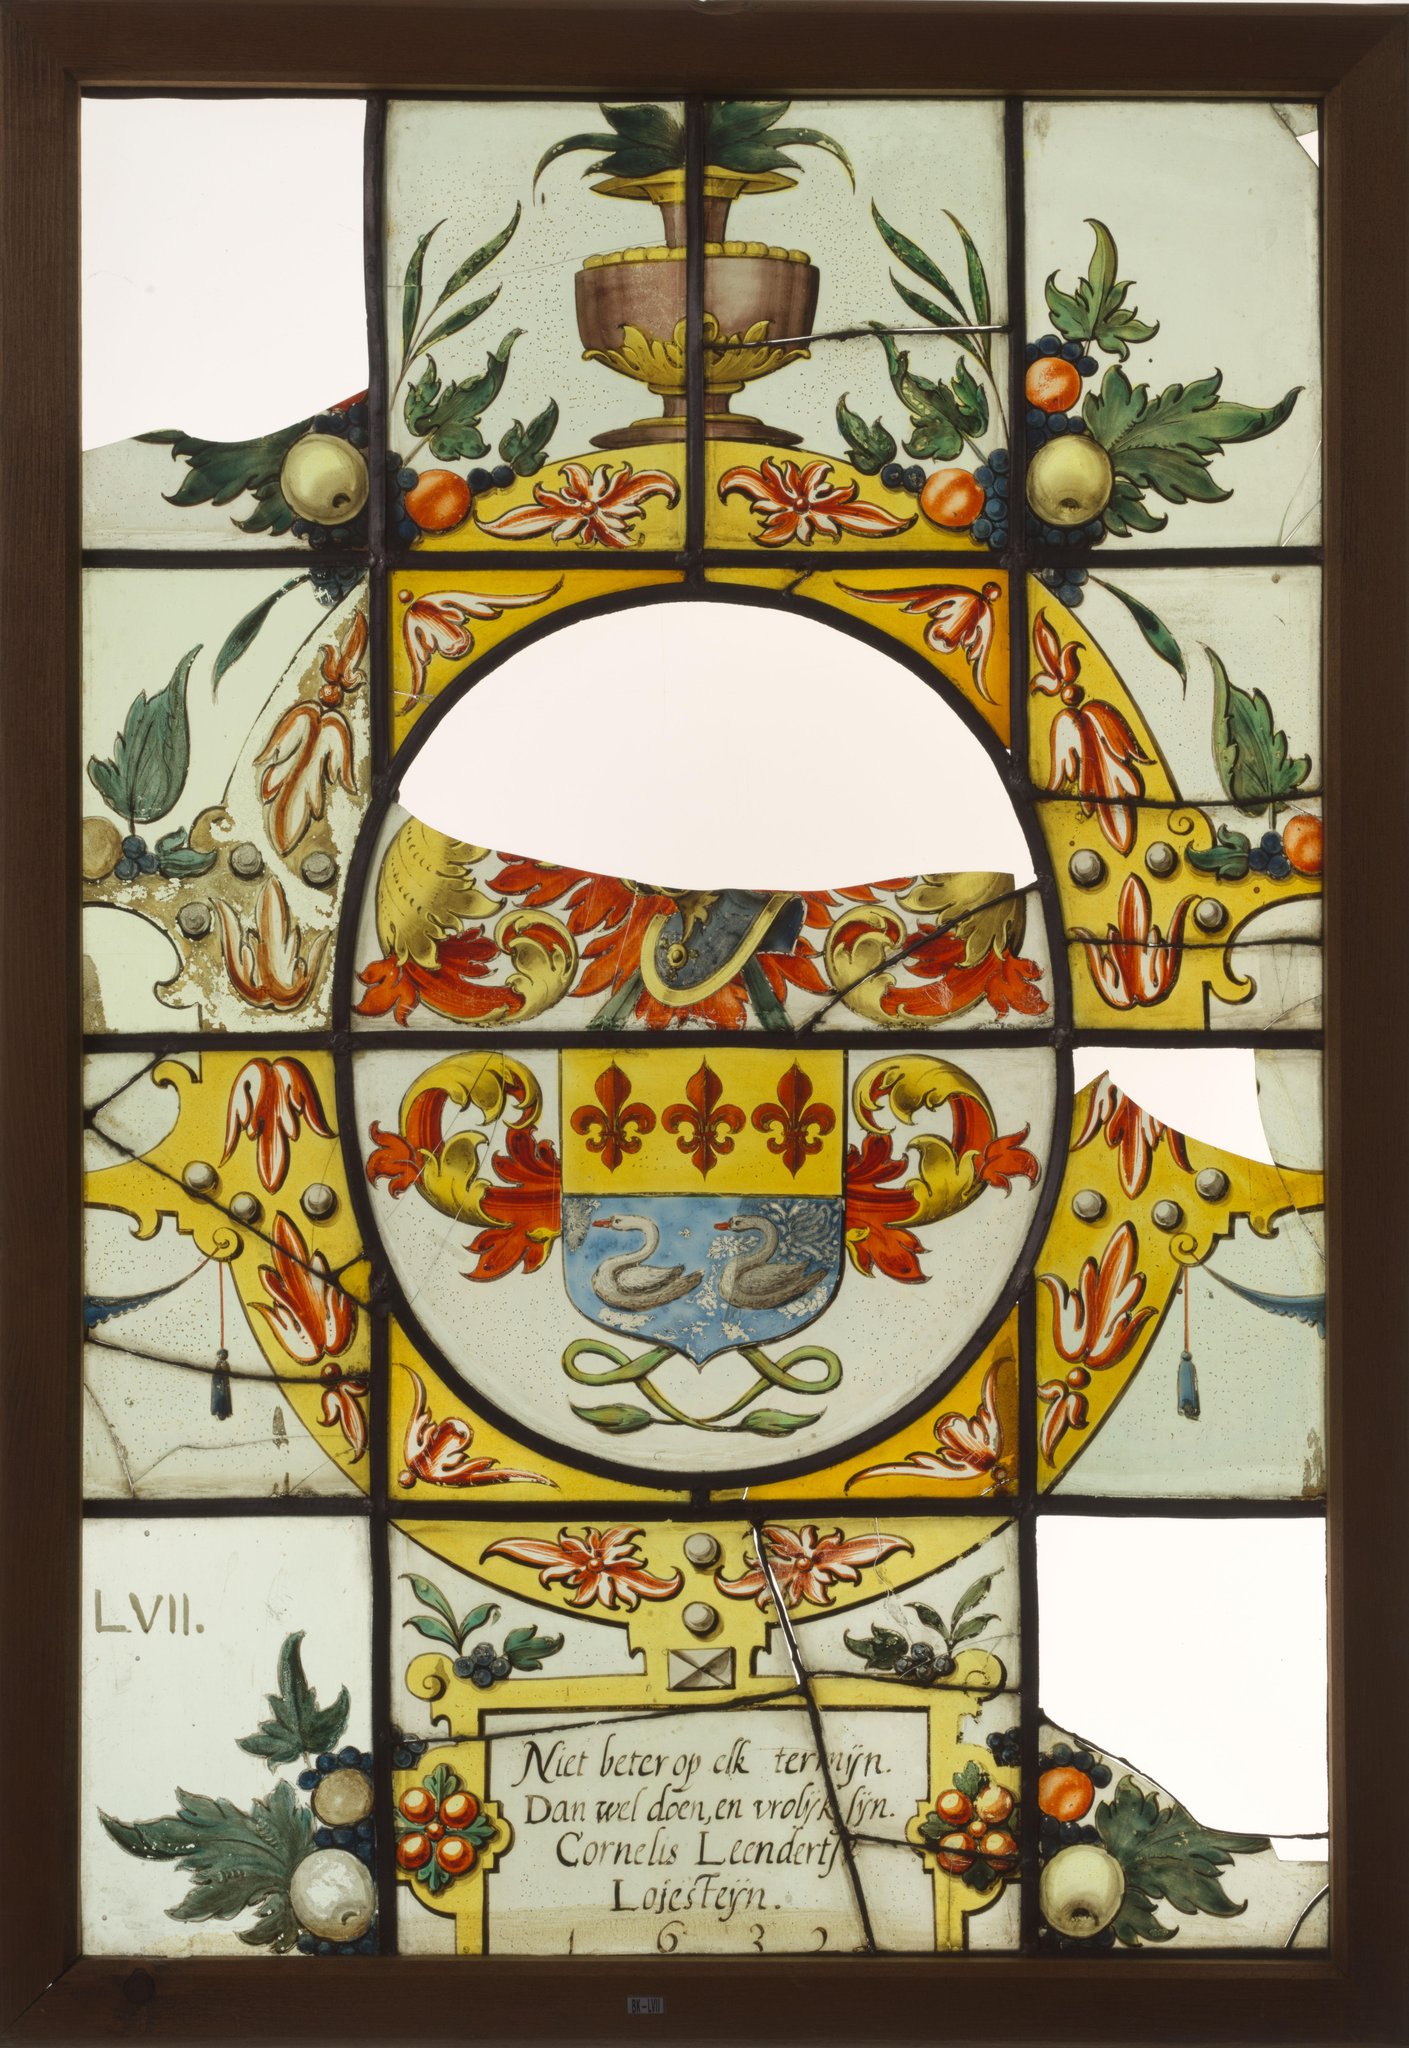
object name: light window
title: Ruit met wapen met drie rode lelies en twee witte zwanen met onderschrift "Niet beter op elk termijn. Dan wel doen, en vrolijk zijn. Cornelis Leendertsz Loiesteyn 1632"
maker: Anonymous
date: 1632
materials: glass, lead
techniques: leading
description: Gekleurd wapen in versierde, gekleurde rand. In het wapenschild drie rode lelies en twee witte zwanen. Onderschrift "Niet beter op elk termijn. Dan wel doen, en vrolijk zijn. Cornelis Leendertsz Loiesteyn 1632".